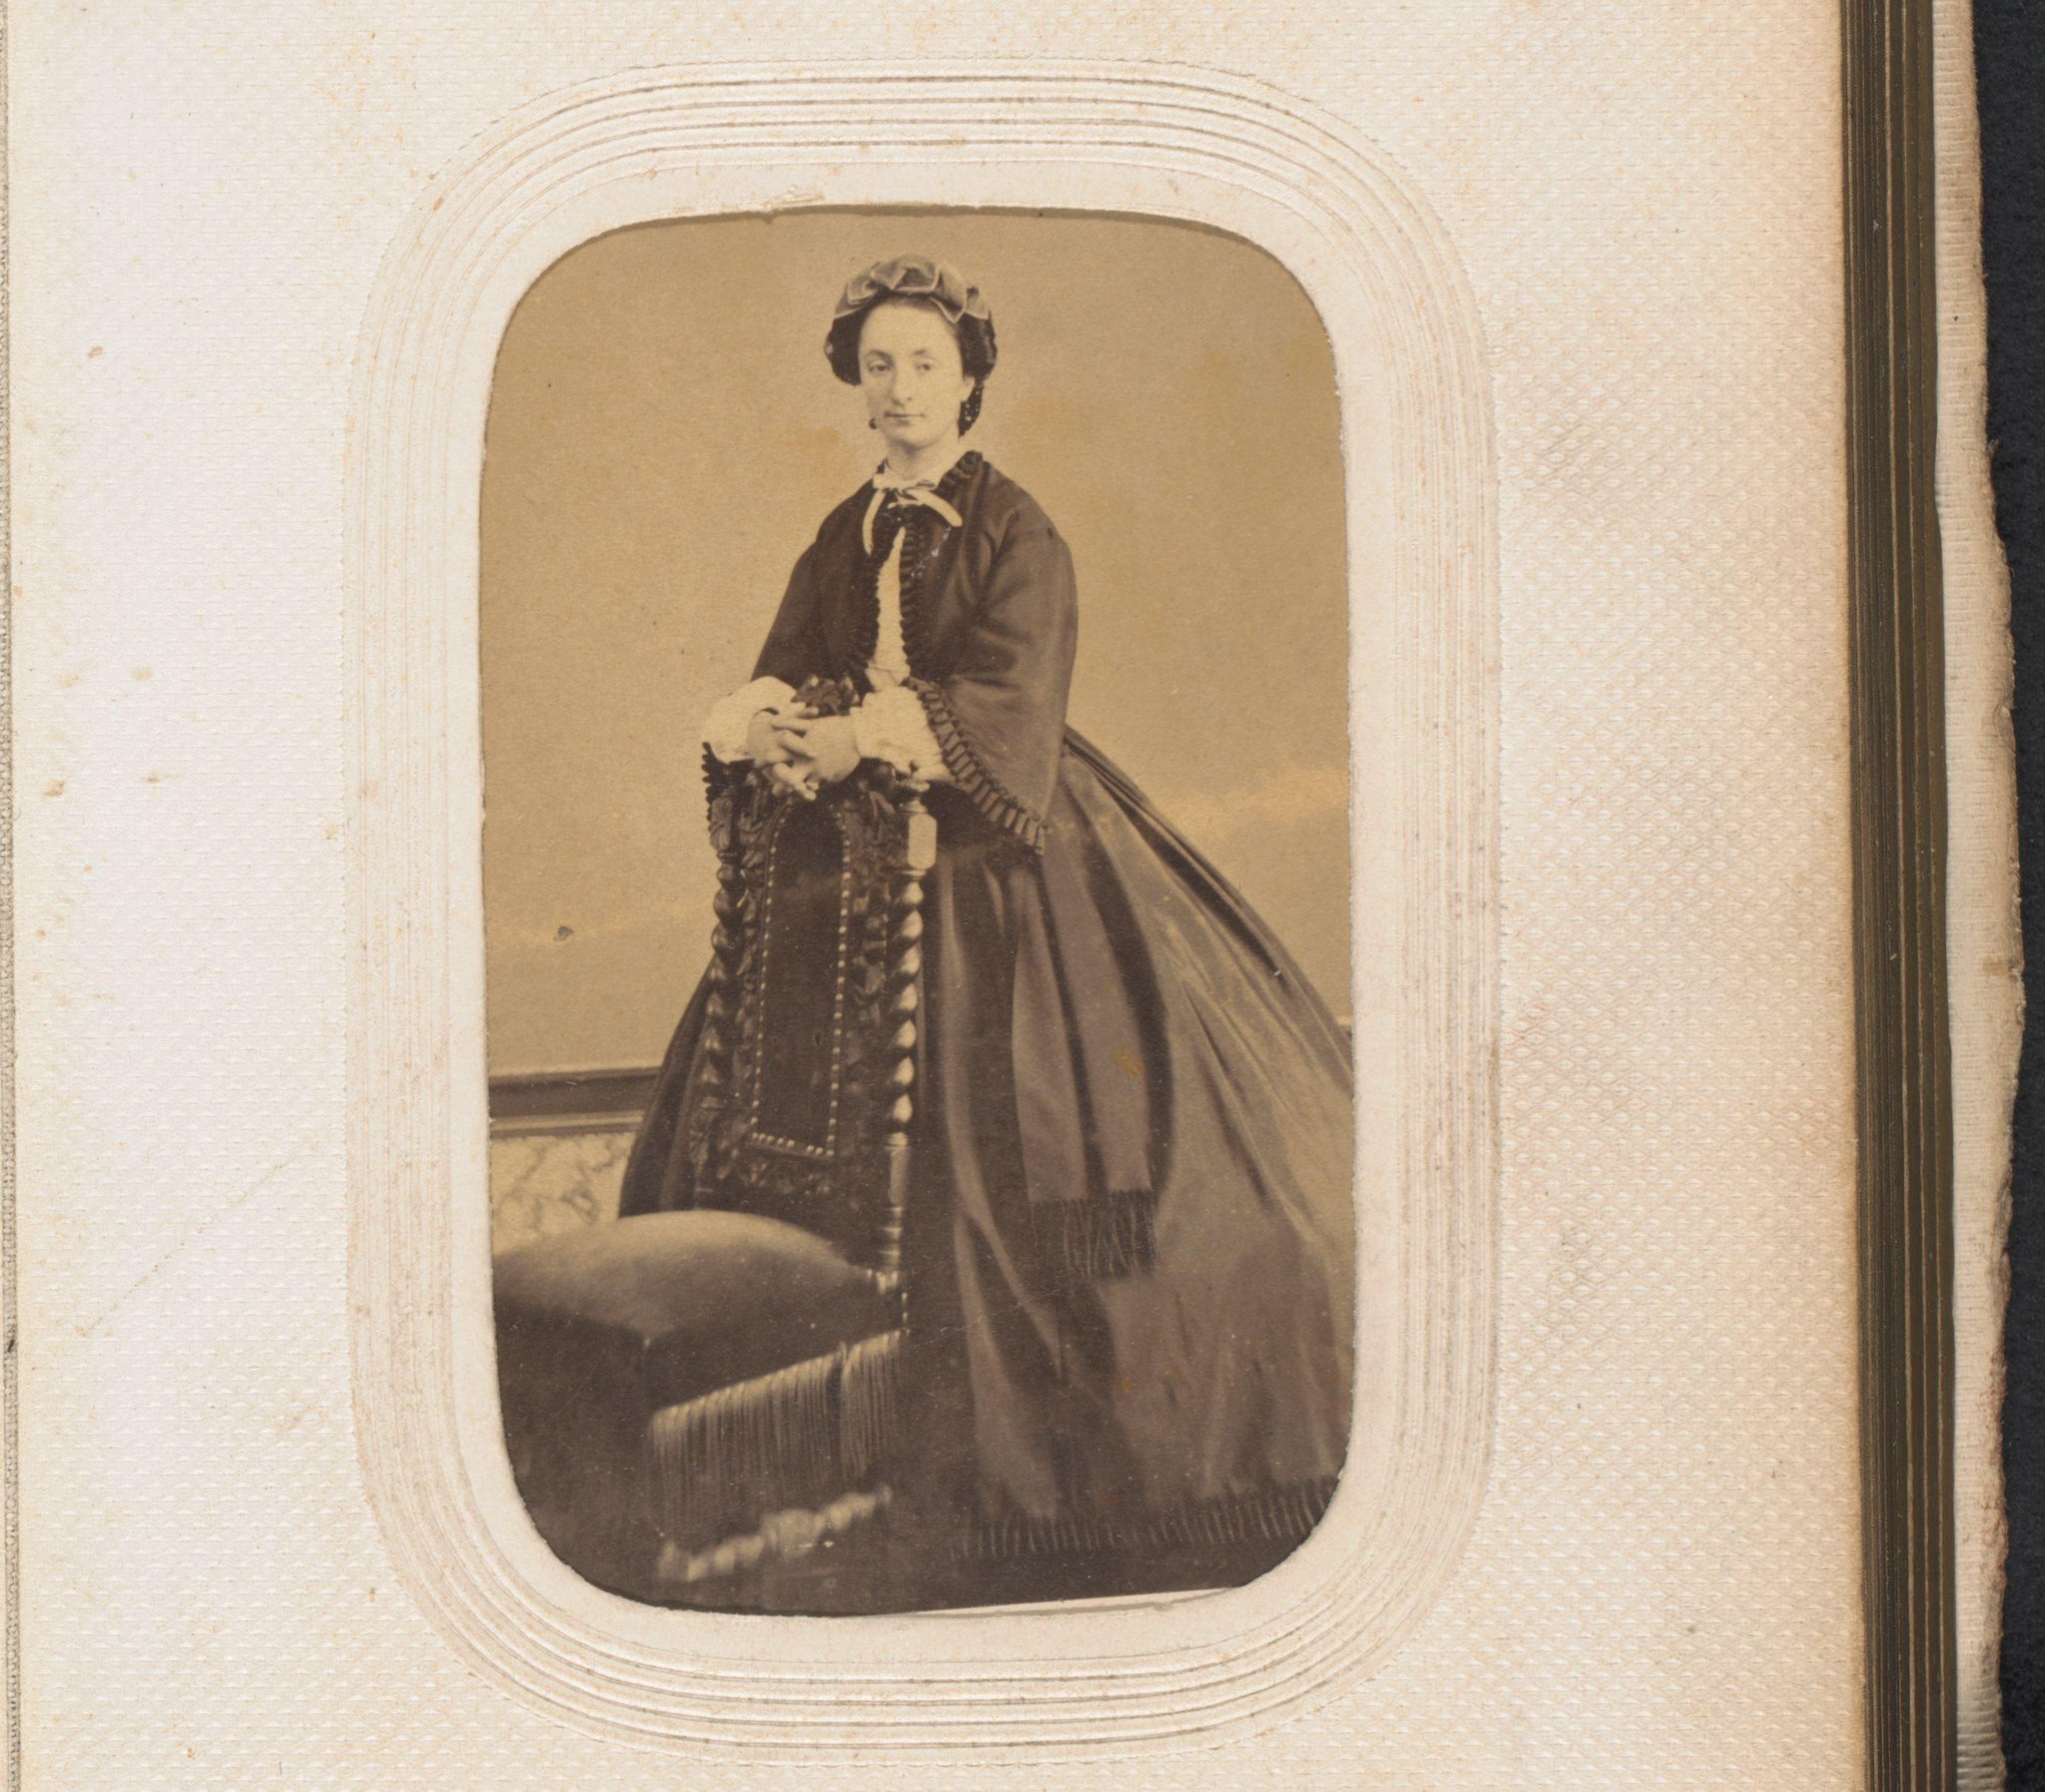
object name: photograph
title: Portret van een staande vrouw bij een stoel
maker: léon girot sr.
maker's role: fotograaf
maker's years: 1810-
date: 1859-1865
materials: cardboard, photographic support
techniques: albumen print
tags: adult woman, historical persons, chair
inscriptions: inscription: ‘Rue Ste.Catherine 4, Bordeaux’